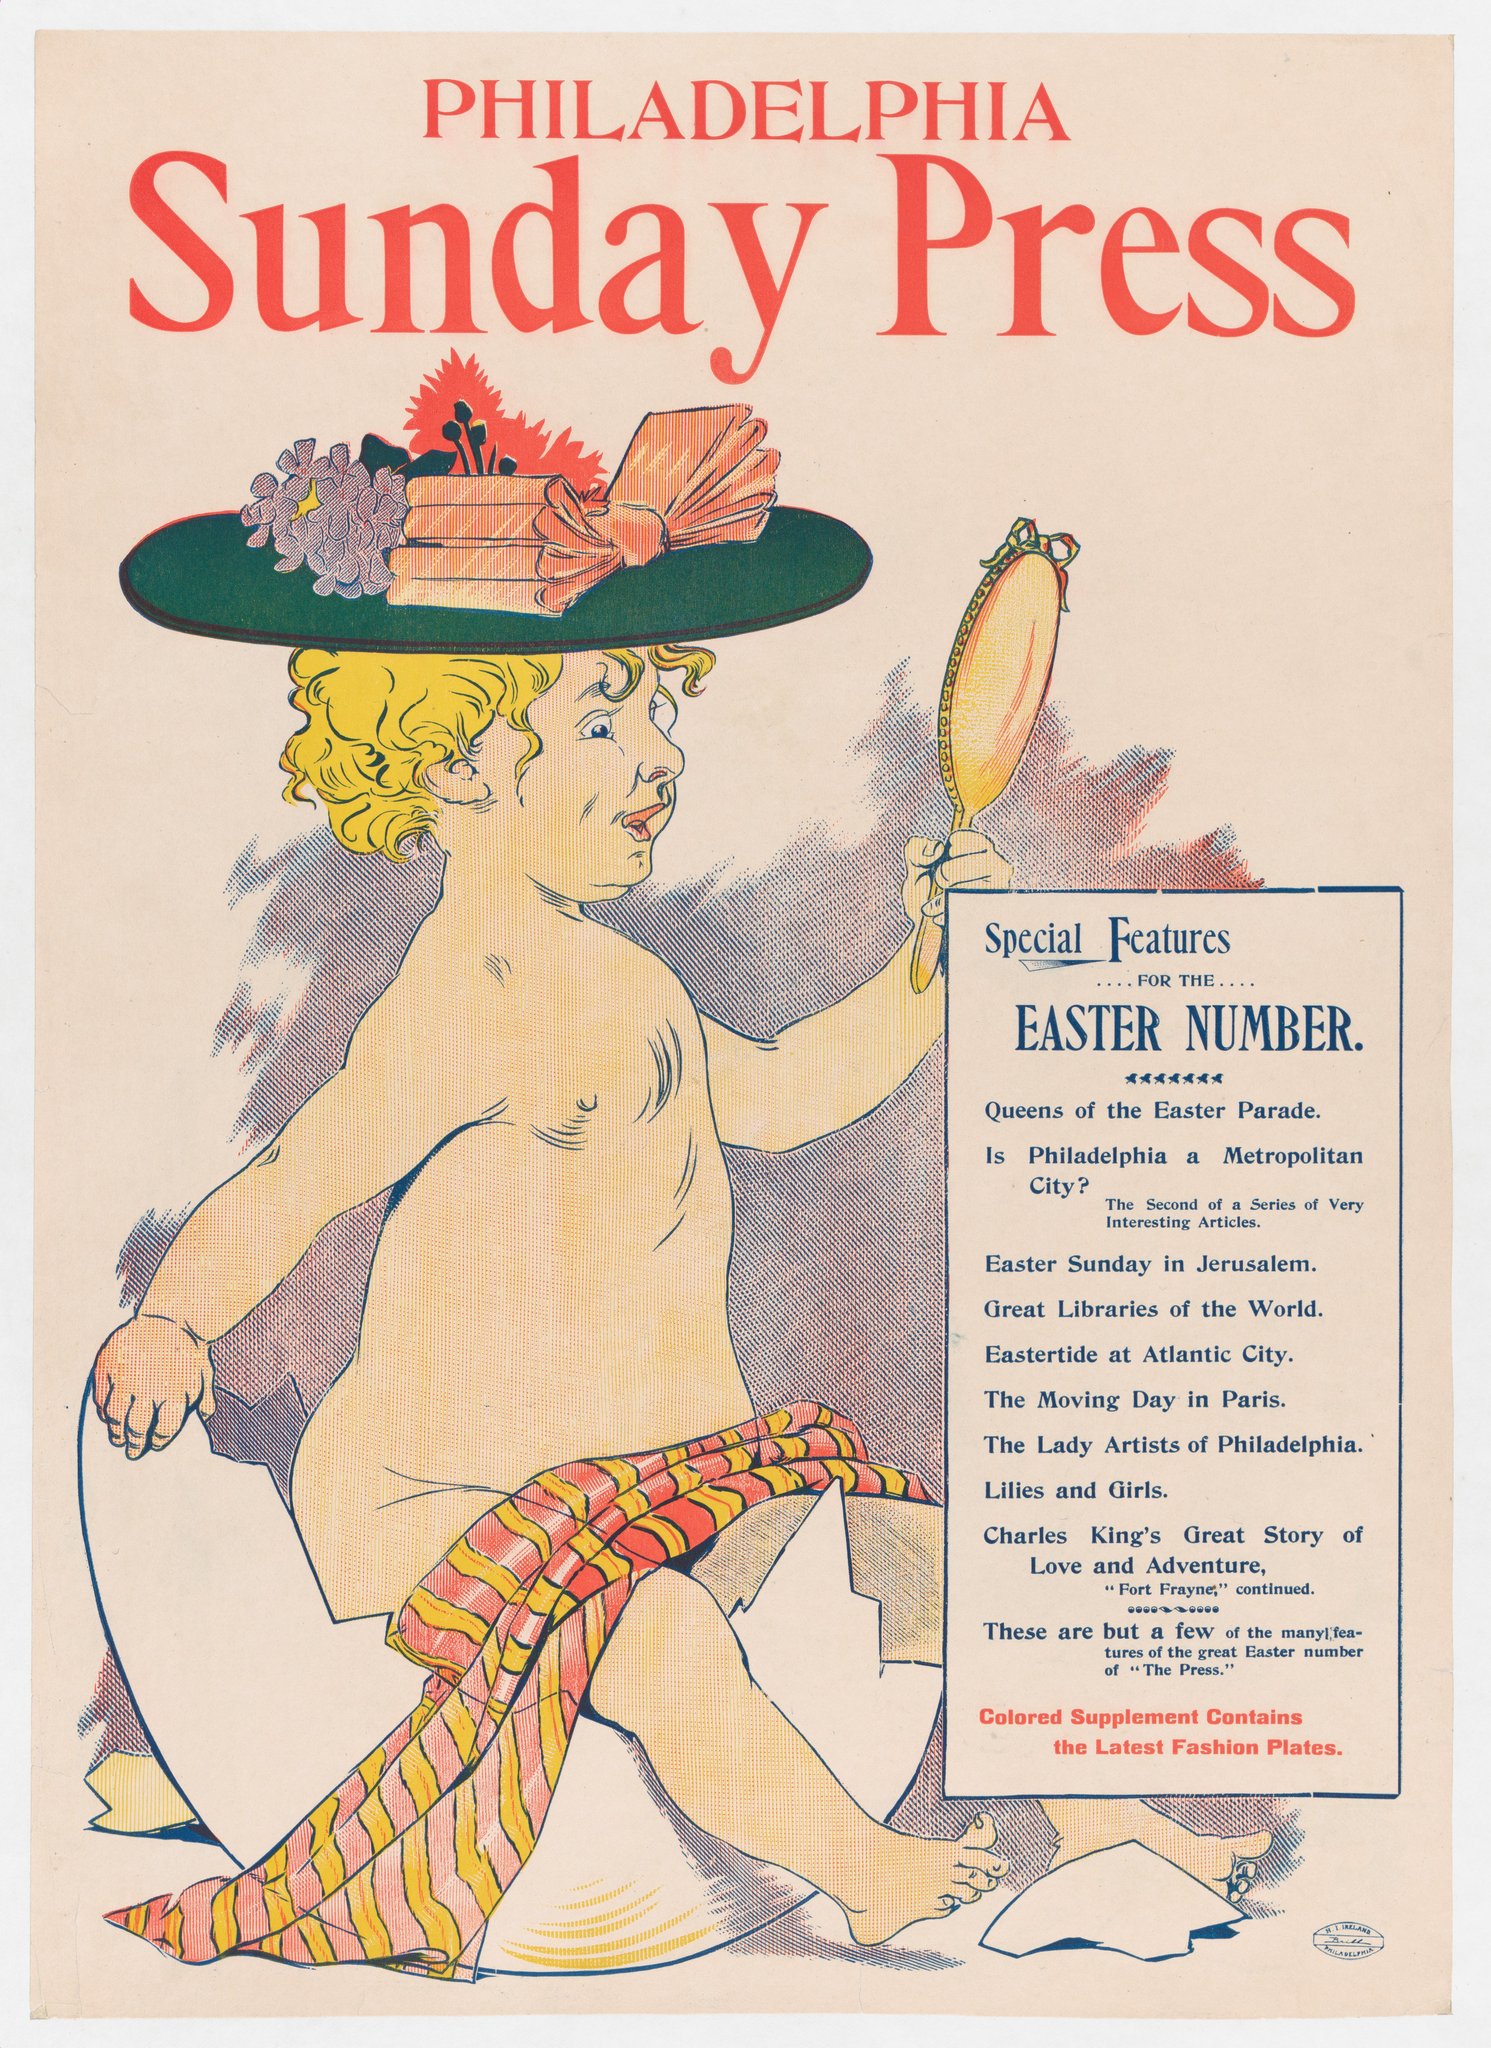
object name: poster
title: Advertisement for Philadelphia Sunday Press, Easter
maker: george reiter brill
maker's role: artist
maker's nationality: american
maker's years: 1867-1918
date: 1896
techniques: lithograph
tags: children